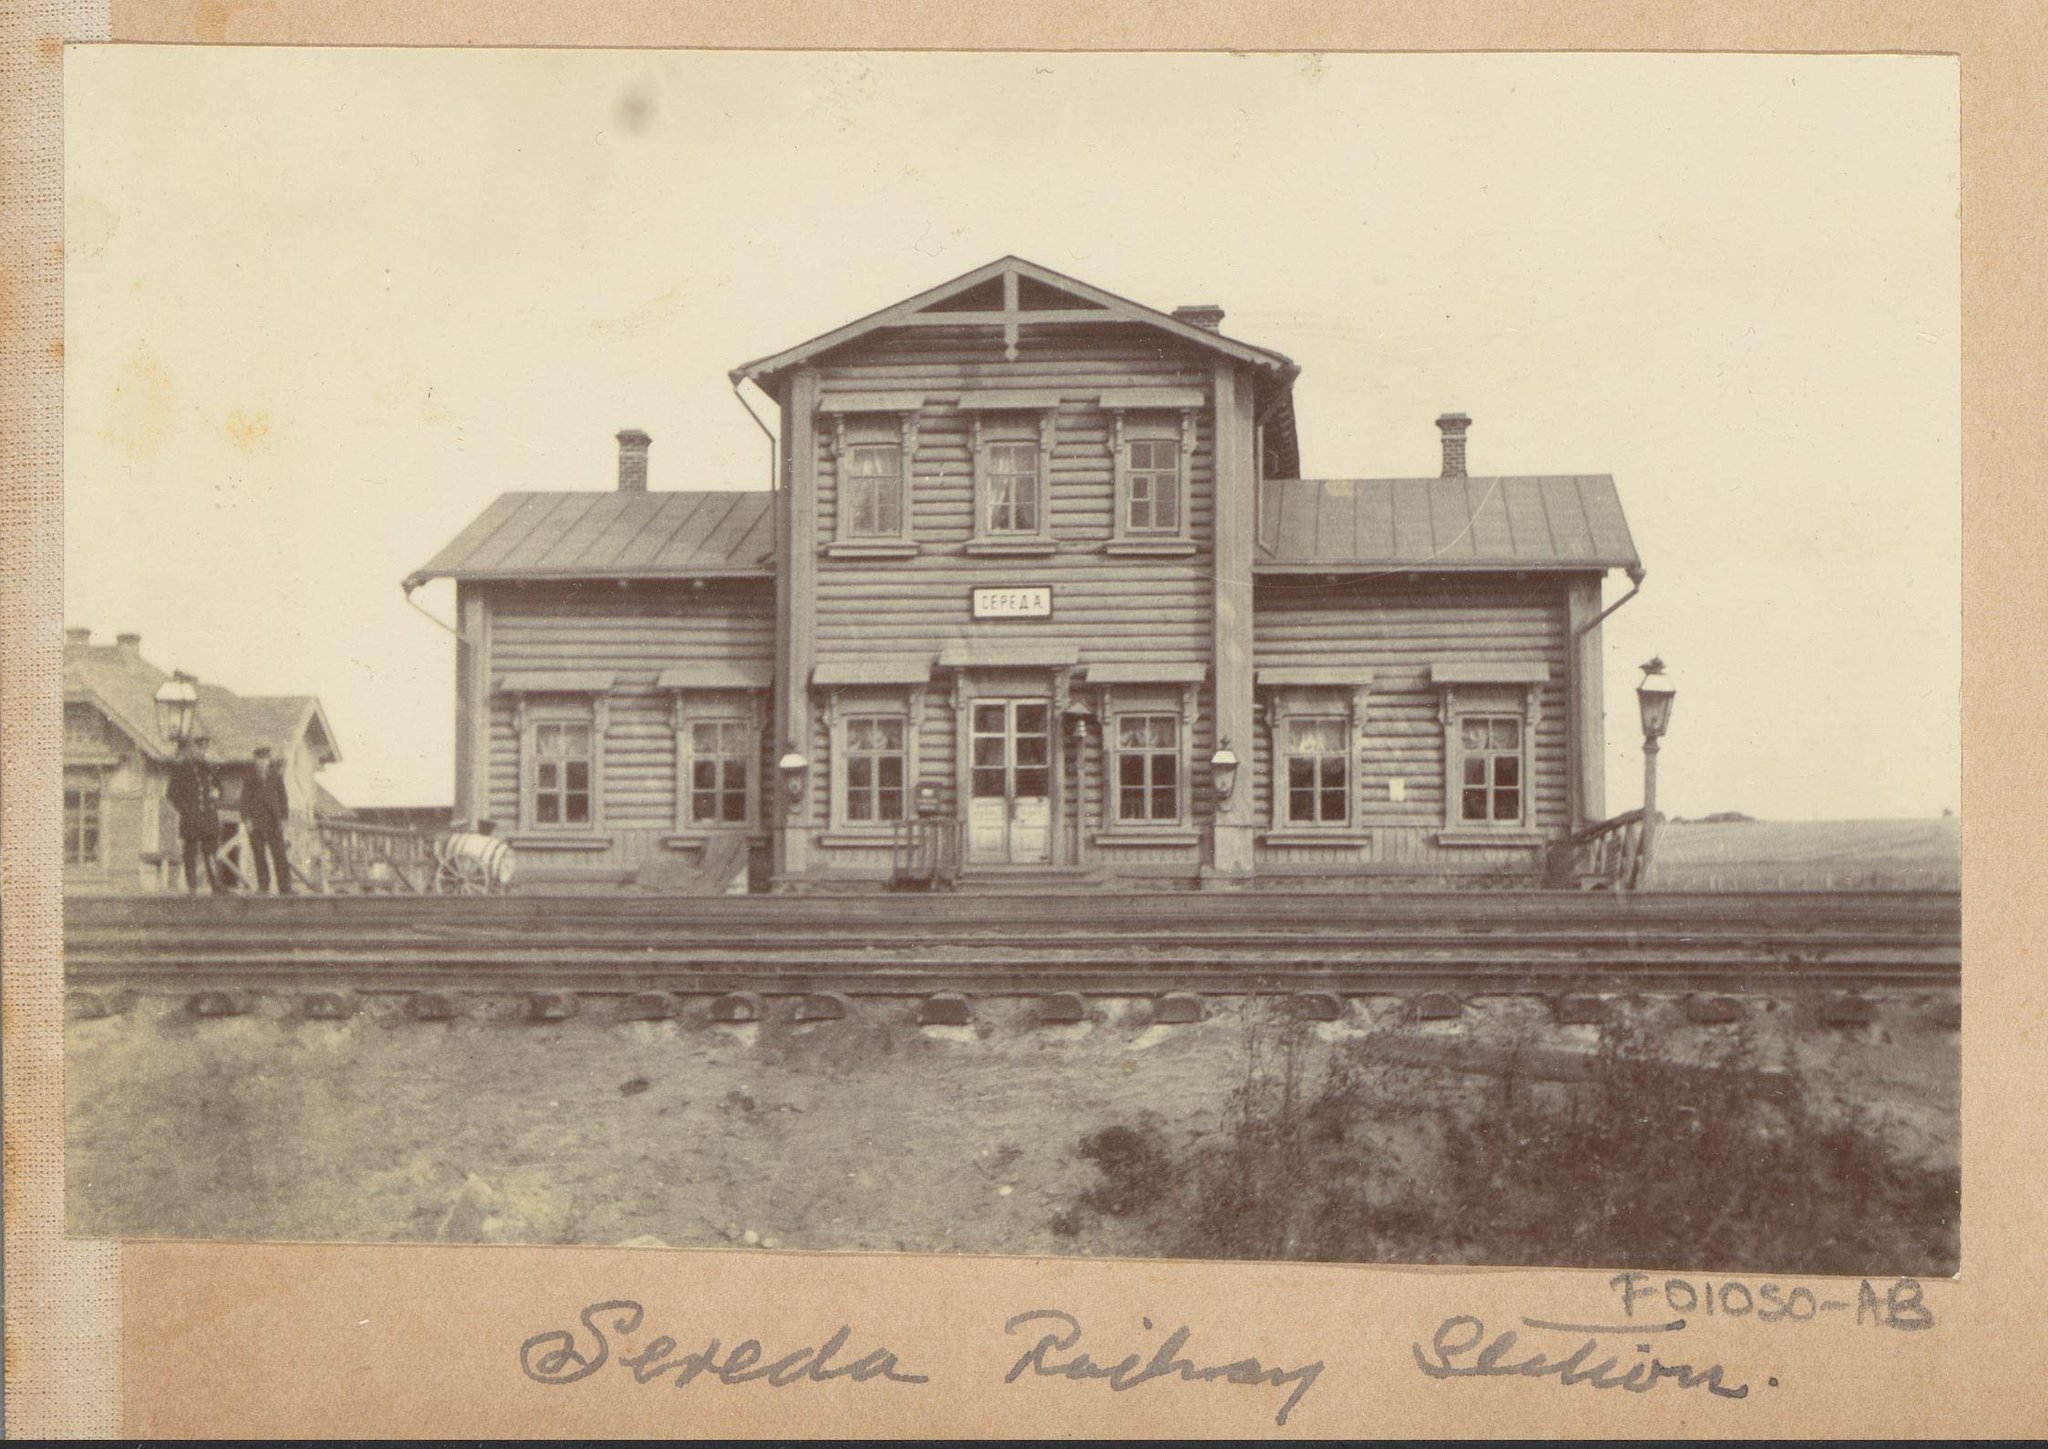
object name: photograph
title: Houten stationsgebouw van Sereda in Rusland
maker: joseph cheetham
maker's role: engineer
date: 1903-1904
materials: photographic support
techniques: gelatin silver print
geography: russia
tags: railway, train, façade (of house or building), station; shelter (railway, tramway), russia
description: Onderdeel van Fotoalbum van de Engelse familie Cheetham met opnames van hun verblijf in Rusland.